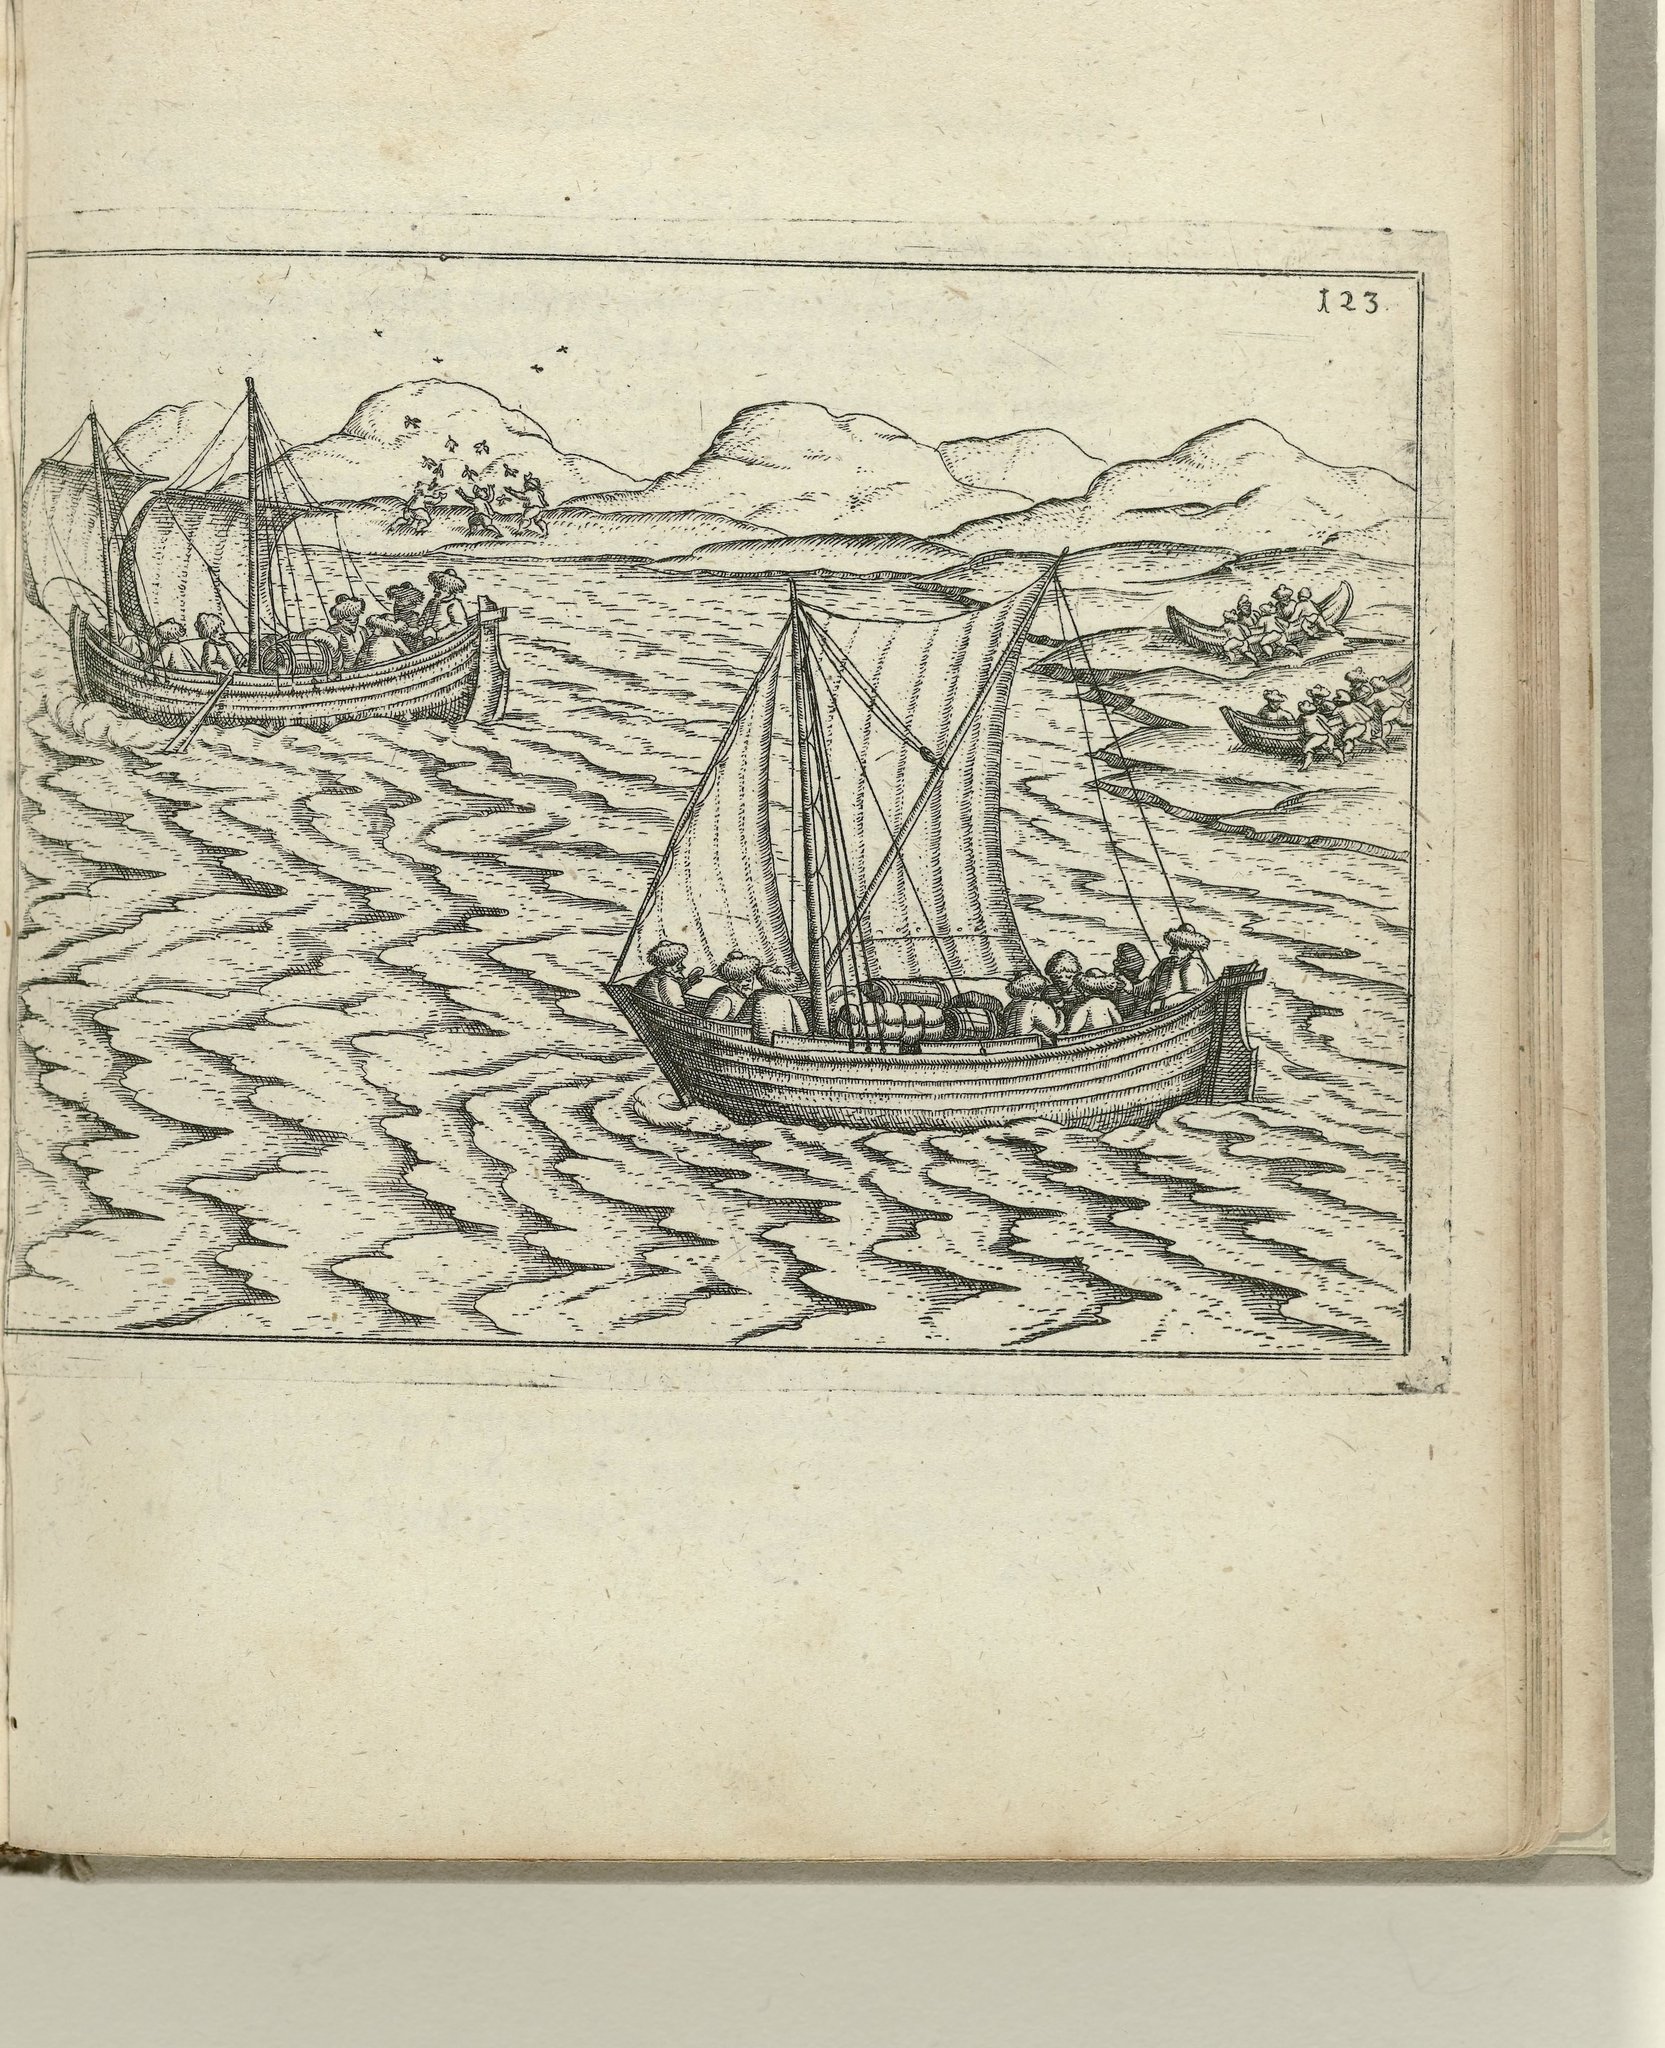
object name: print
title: De boten worden weer te water gelaten, 1597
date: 1598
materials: paper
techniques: engraving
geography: nuremberg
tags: willem barendsz., amsterdam, jacob van heemskerck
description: Nadat de mannen de boten over kruiseiland gesleept hebben, laten ze de boten weer te water. Tegenover pagina 123 in: 'Warhafftige Relation. Der dreyen newen unerhörten seltzamen Schiffart so die Holländischen und Seeländischen Schiff....Anno 1594, 1595 und 1596 verricht' (1598).